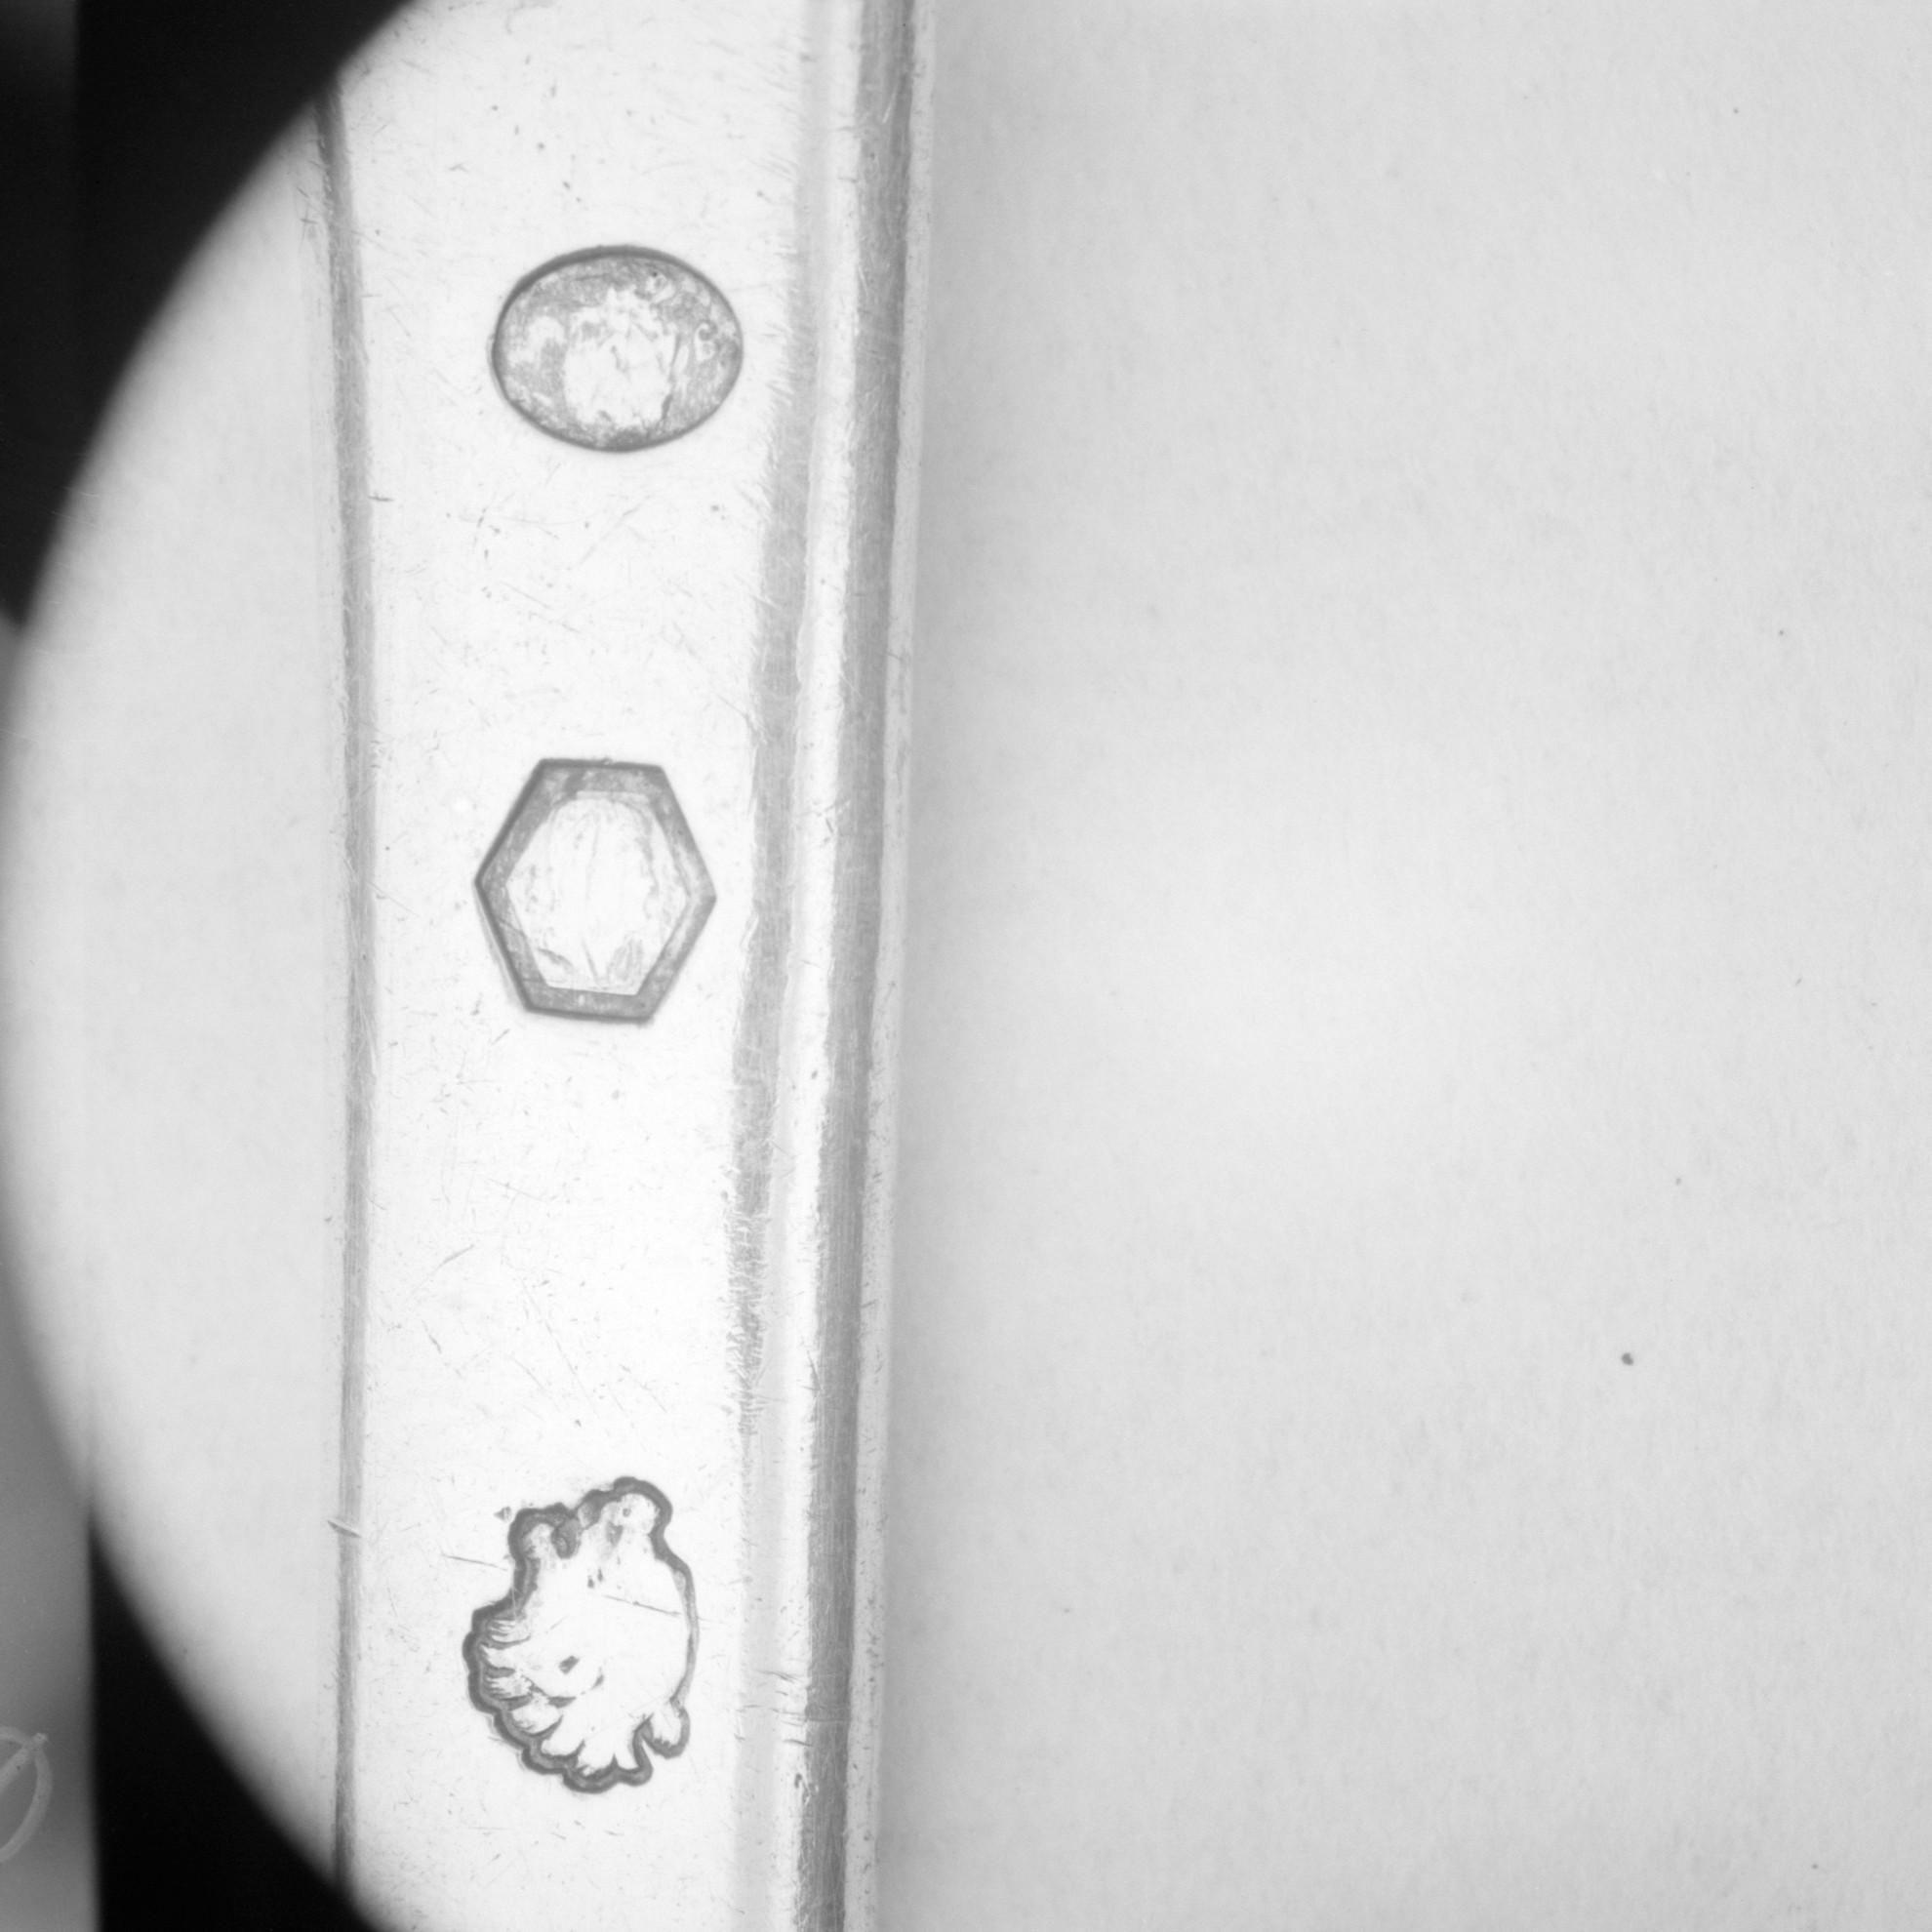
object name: spoon handle section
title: Section of a spoon handle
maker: pierre-charles micalef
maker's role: maker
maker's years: 1743-1836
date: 1786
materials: silver